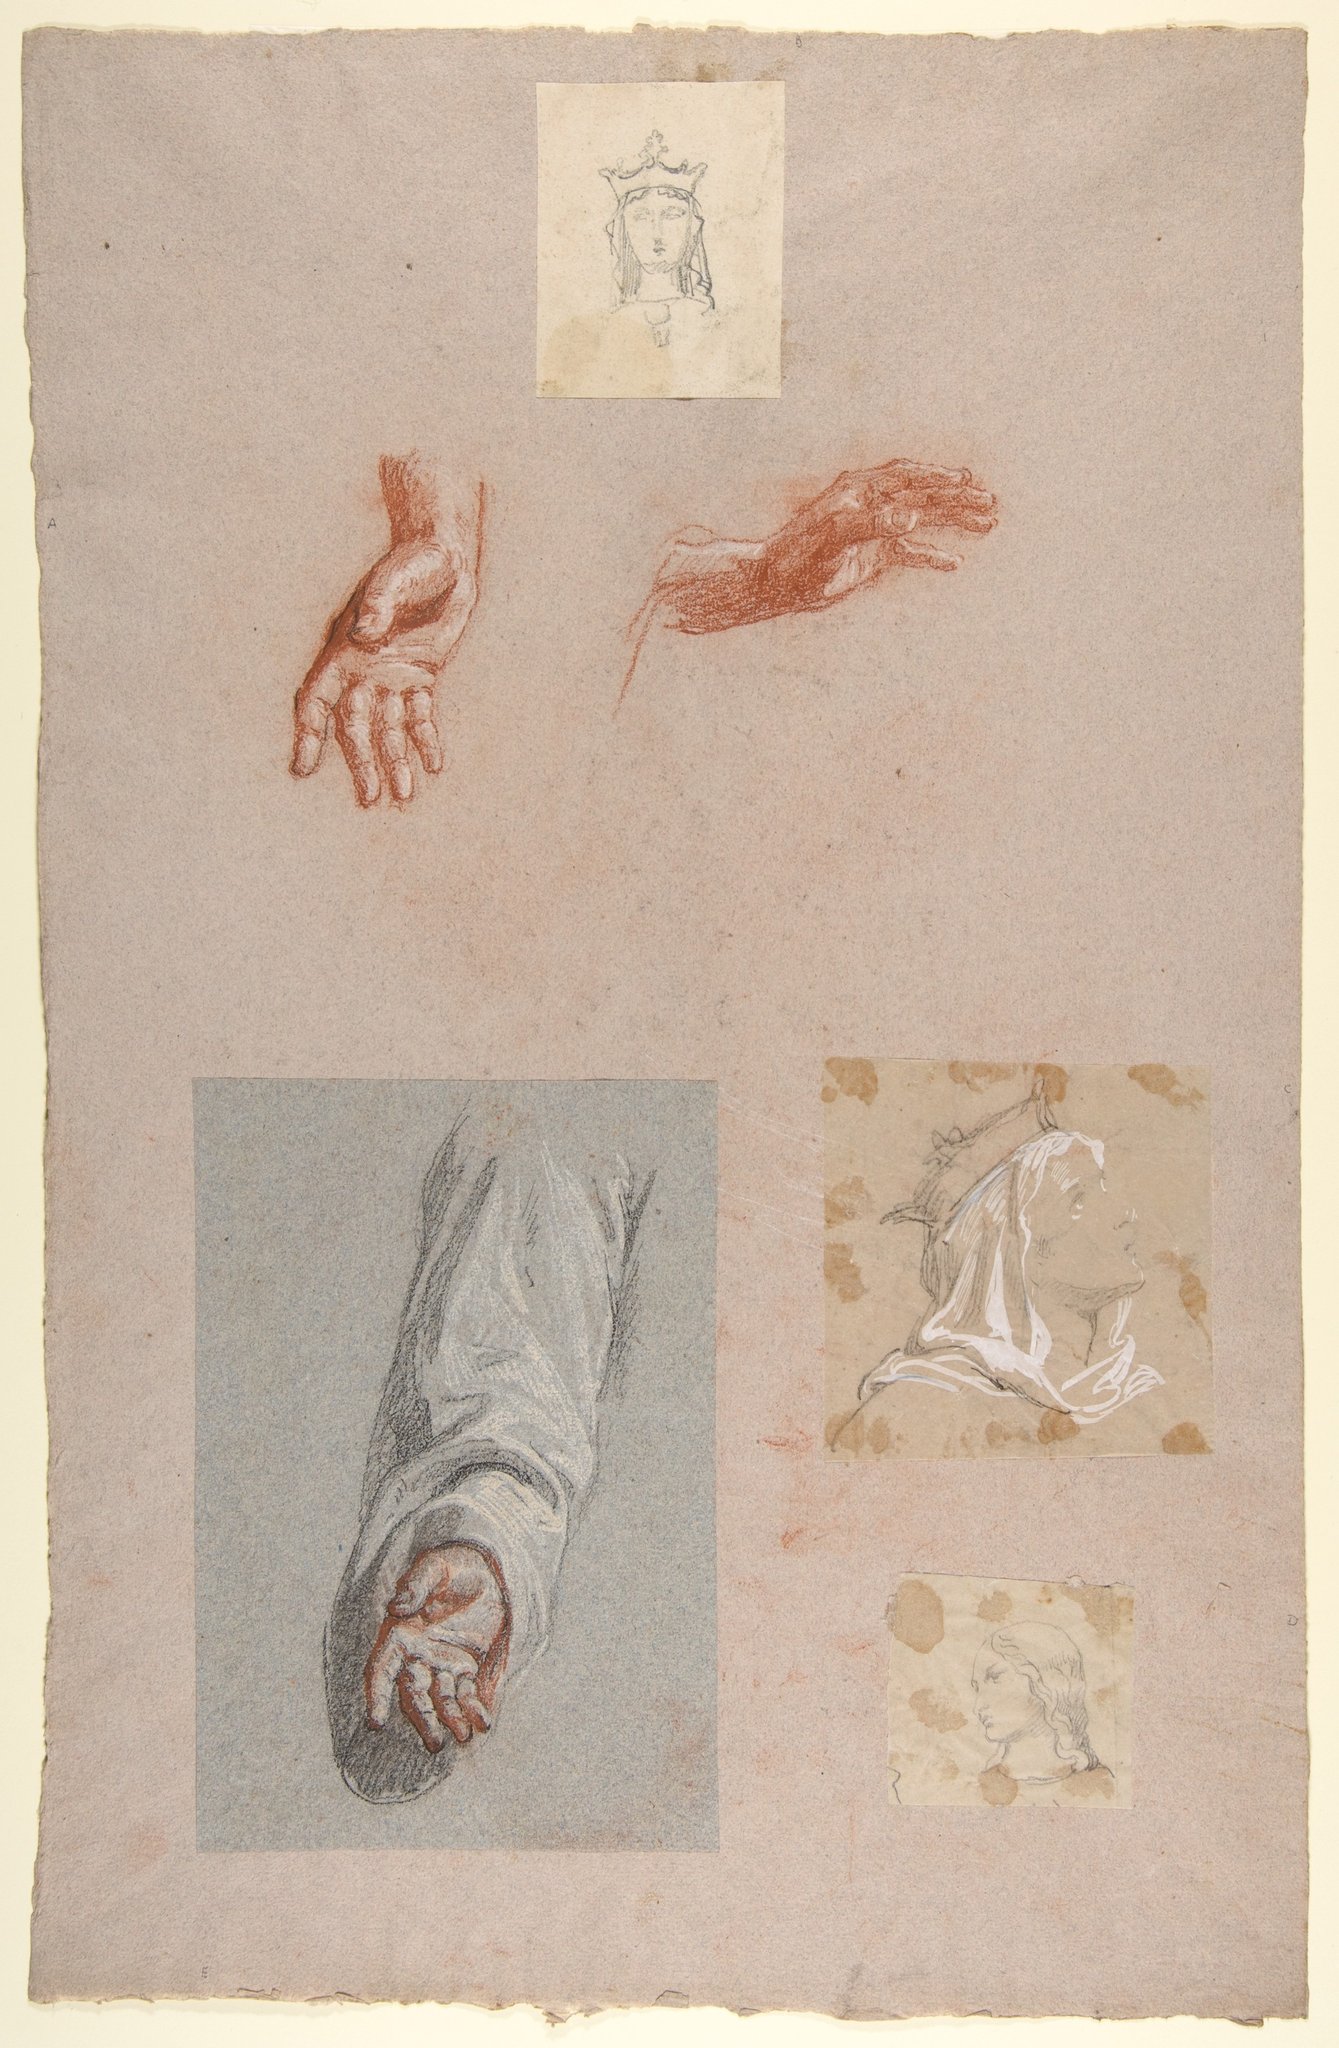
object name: drawing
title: a. Hands of Saint Remi (lower register); b. Head of Saint Clotilde (upper register); c. Head of Saint Clotilde (lower register); d. Head of an Angel (upper register); e. Hand and Sleeve of Saint Remi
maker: isidore pils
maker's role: artist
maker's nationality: french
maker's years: 1813-1875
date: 1801-1900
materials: chalk, gouache, graphite, paper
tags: diadems,hands,heads,profiles,women